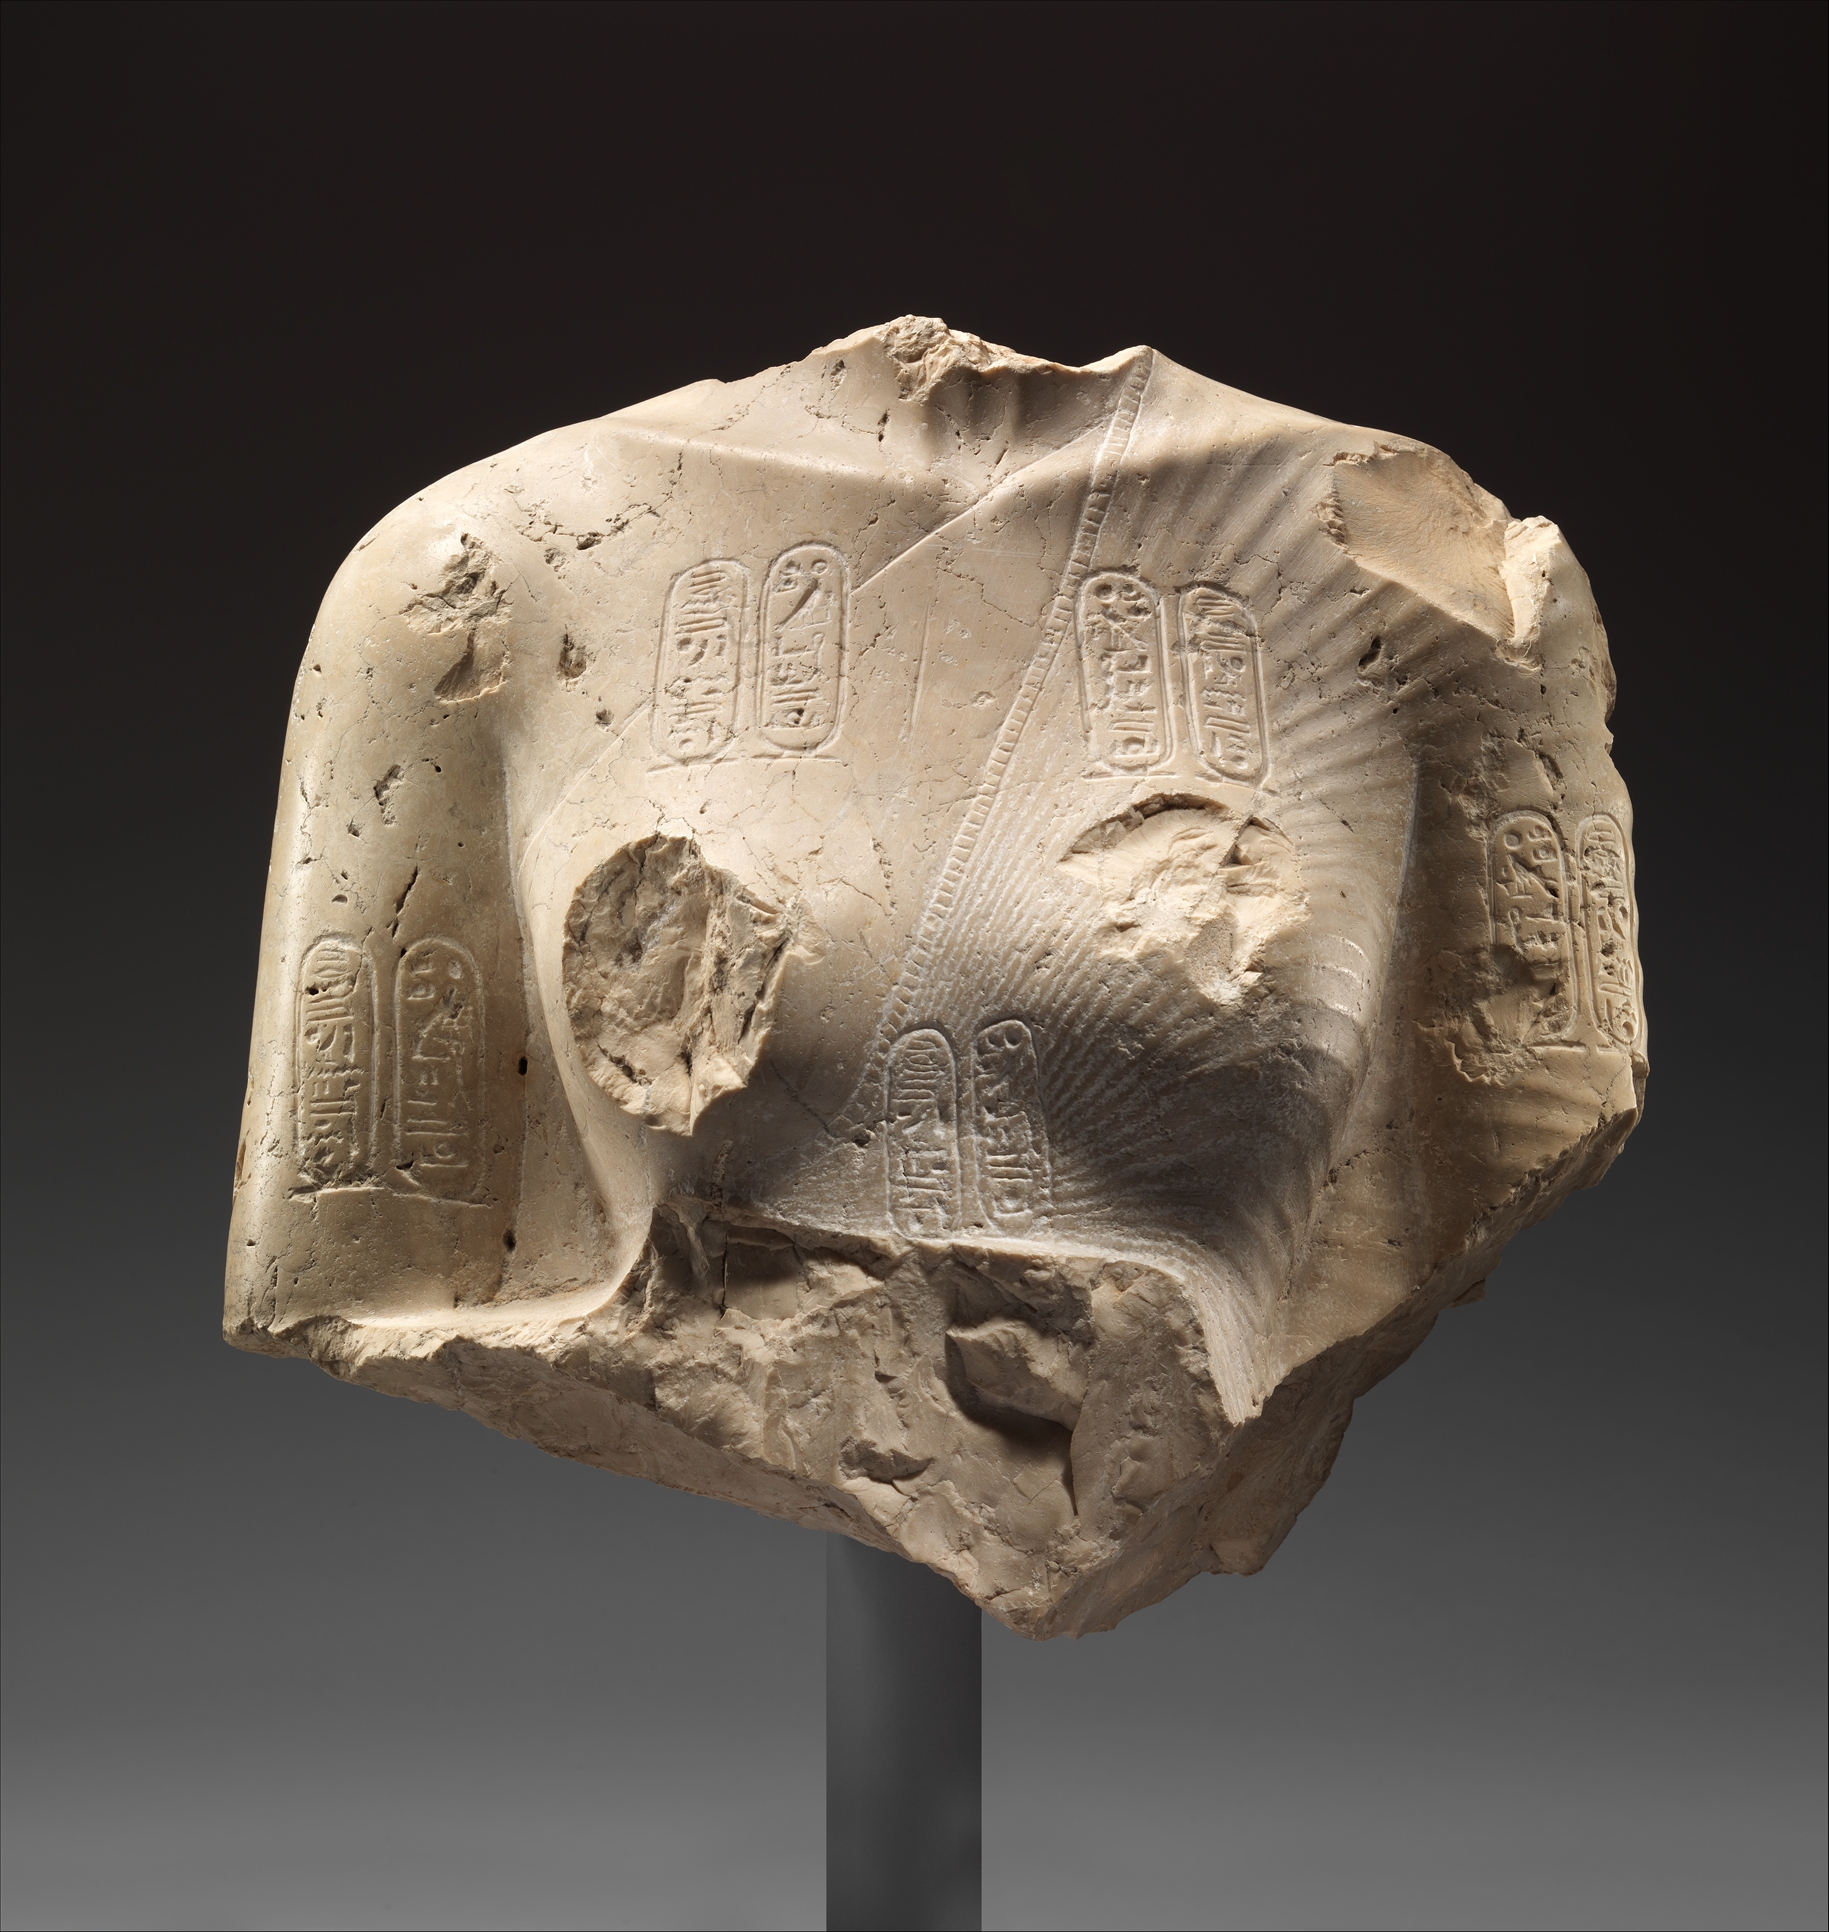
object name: nefertiti torso, aten cartouch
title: Torso of Nefertiti from a dyad holding a stela in front of the bodies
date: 1352-1336 BCE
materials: limestone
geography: egypt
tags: cartouches,nefertiti